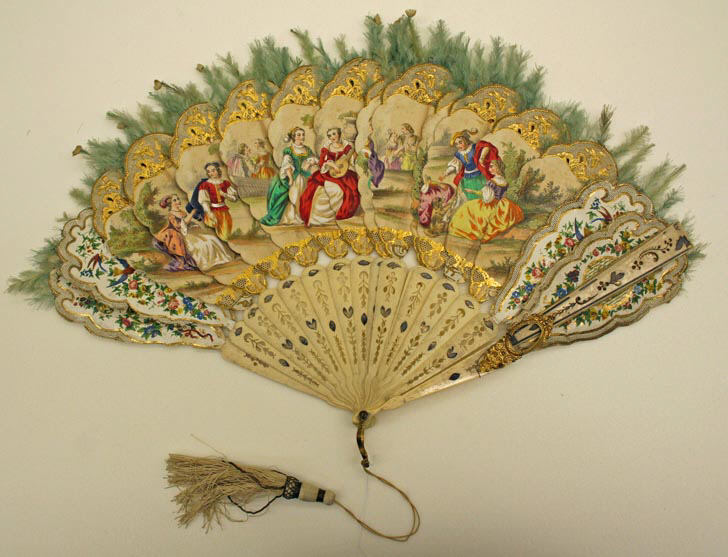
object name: fan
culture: european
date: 1840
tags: men,women,flowers